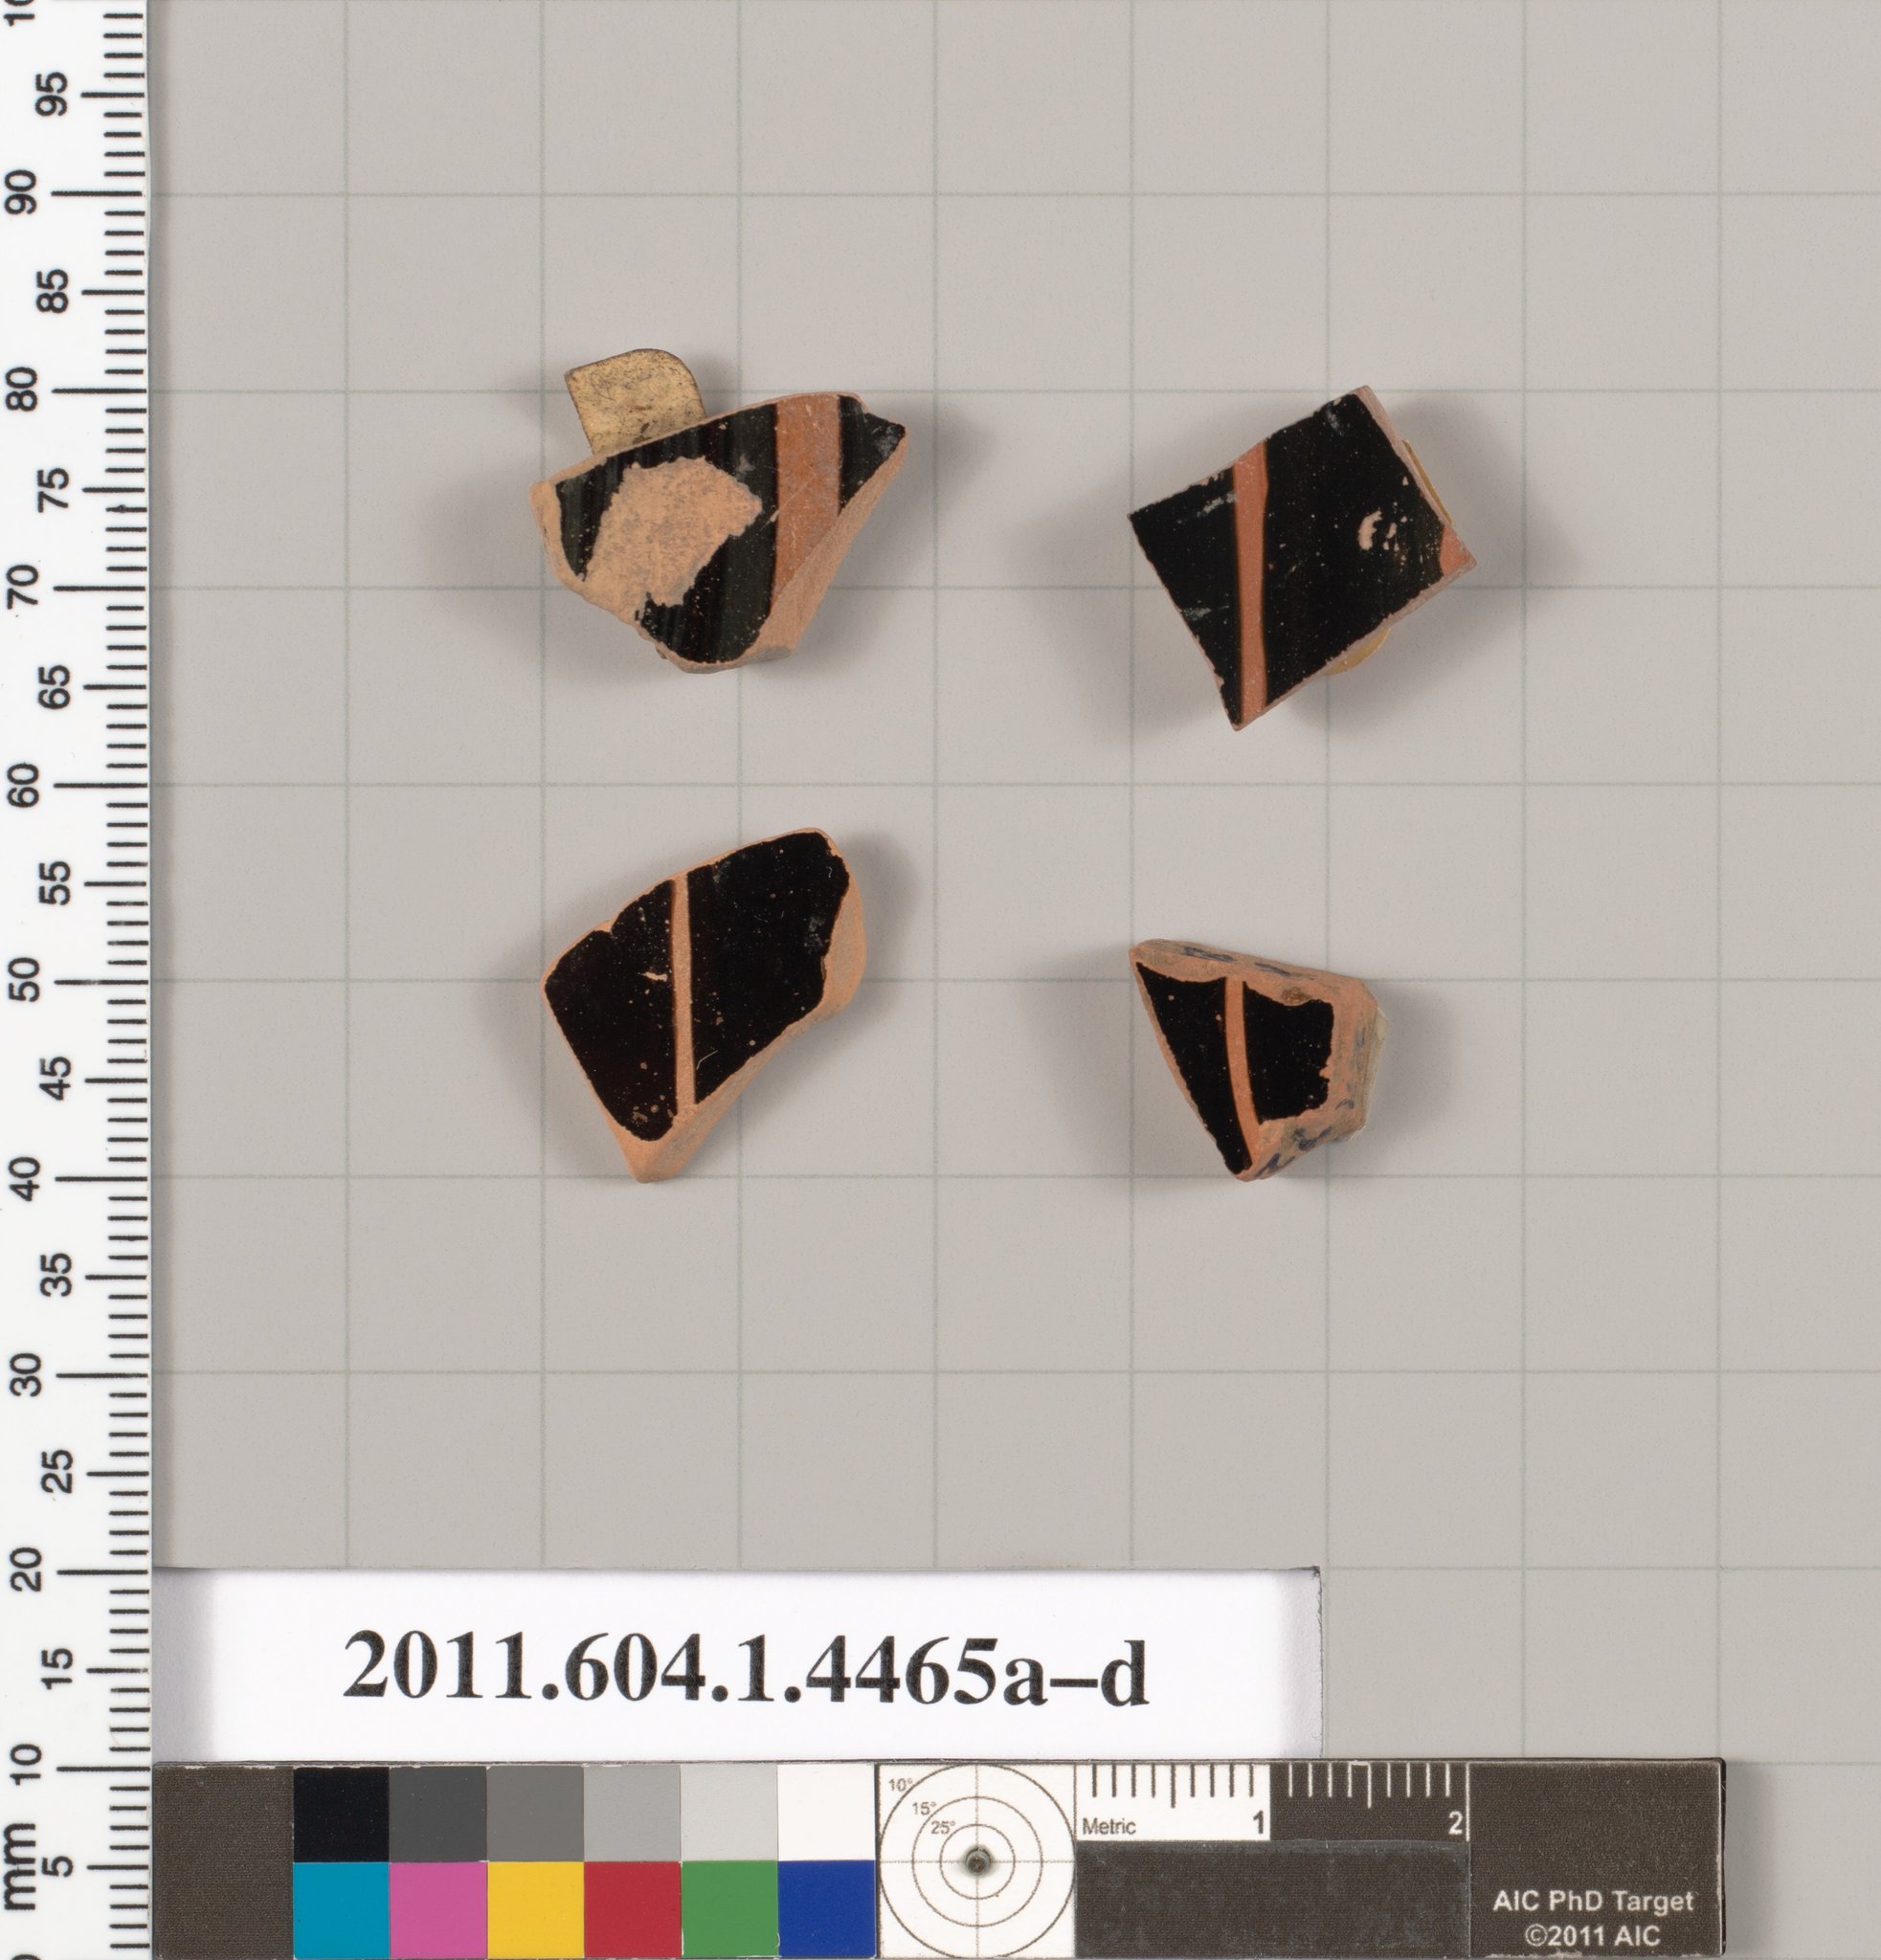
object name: kylix fragment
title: Terracotta fragments of kylikes (drinking cups)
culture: greek, attic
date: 500-451 BCE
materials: terracotta